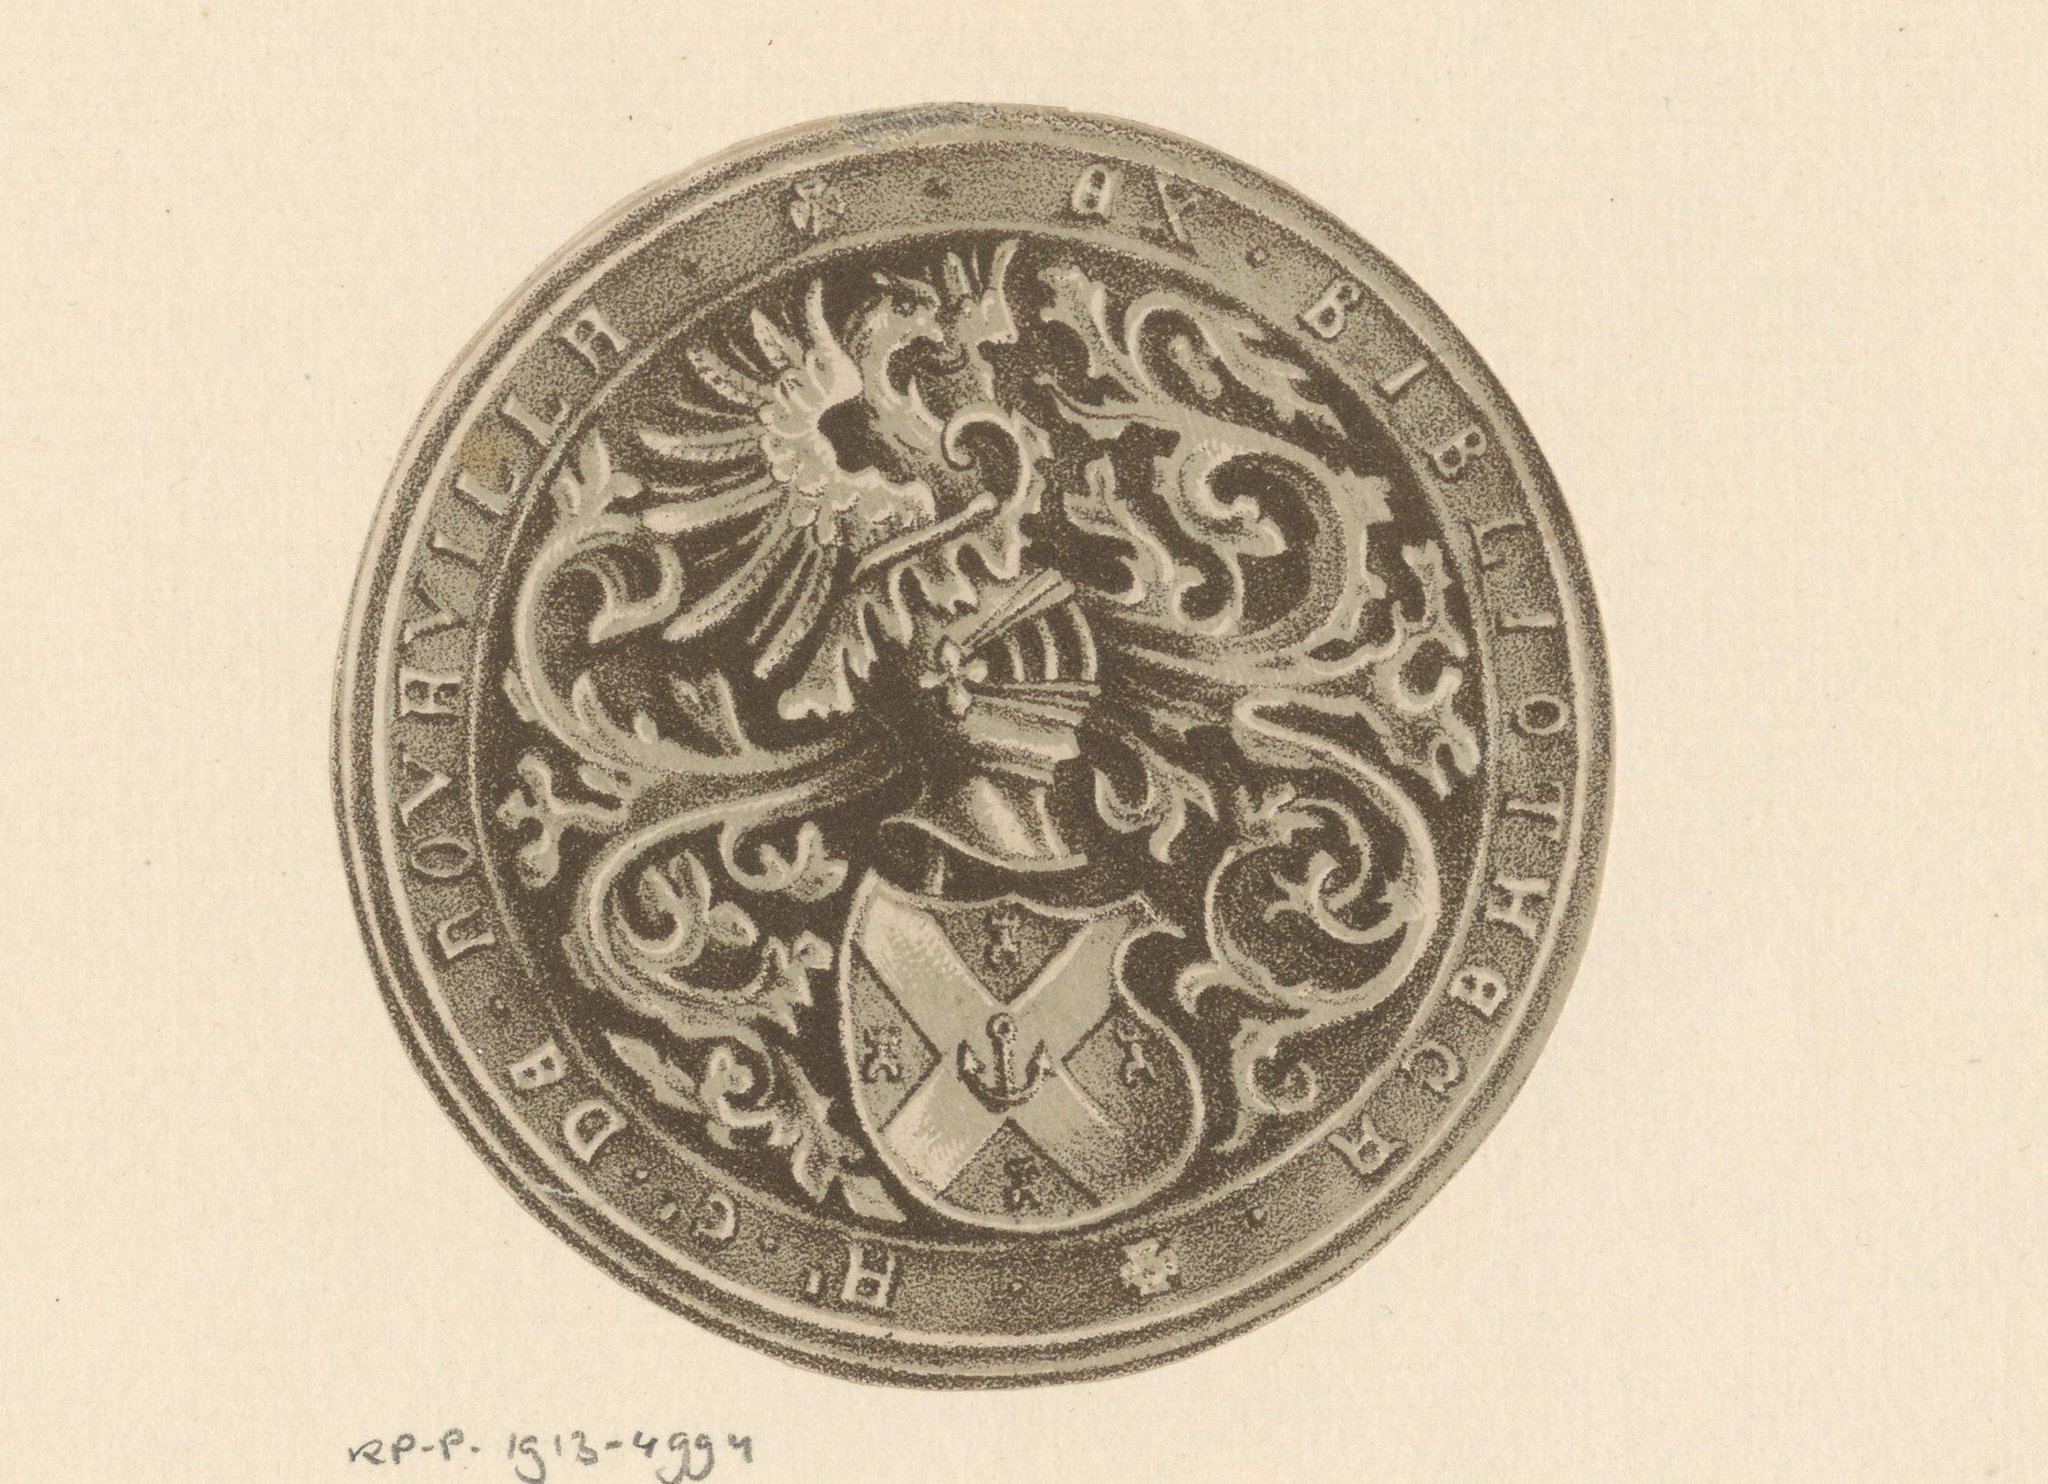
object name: bookplate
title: Ex libris van A.C. da Novavilla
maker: Anonymous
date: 1850-1913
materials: paper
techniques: lithograph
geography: netherlands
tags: parts of ship's exterior: anchor, armorial bearing, heraldry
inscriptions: collector's mark: Lugt 2760, collector's mark: Lugt 2233